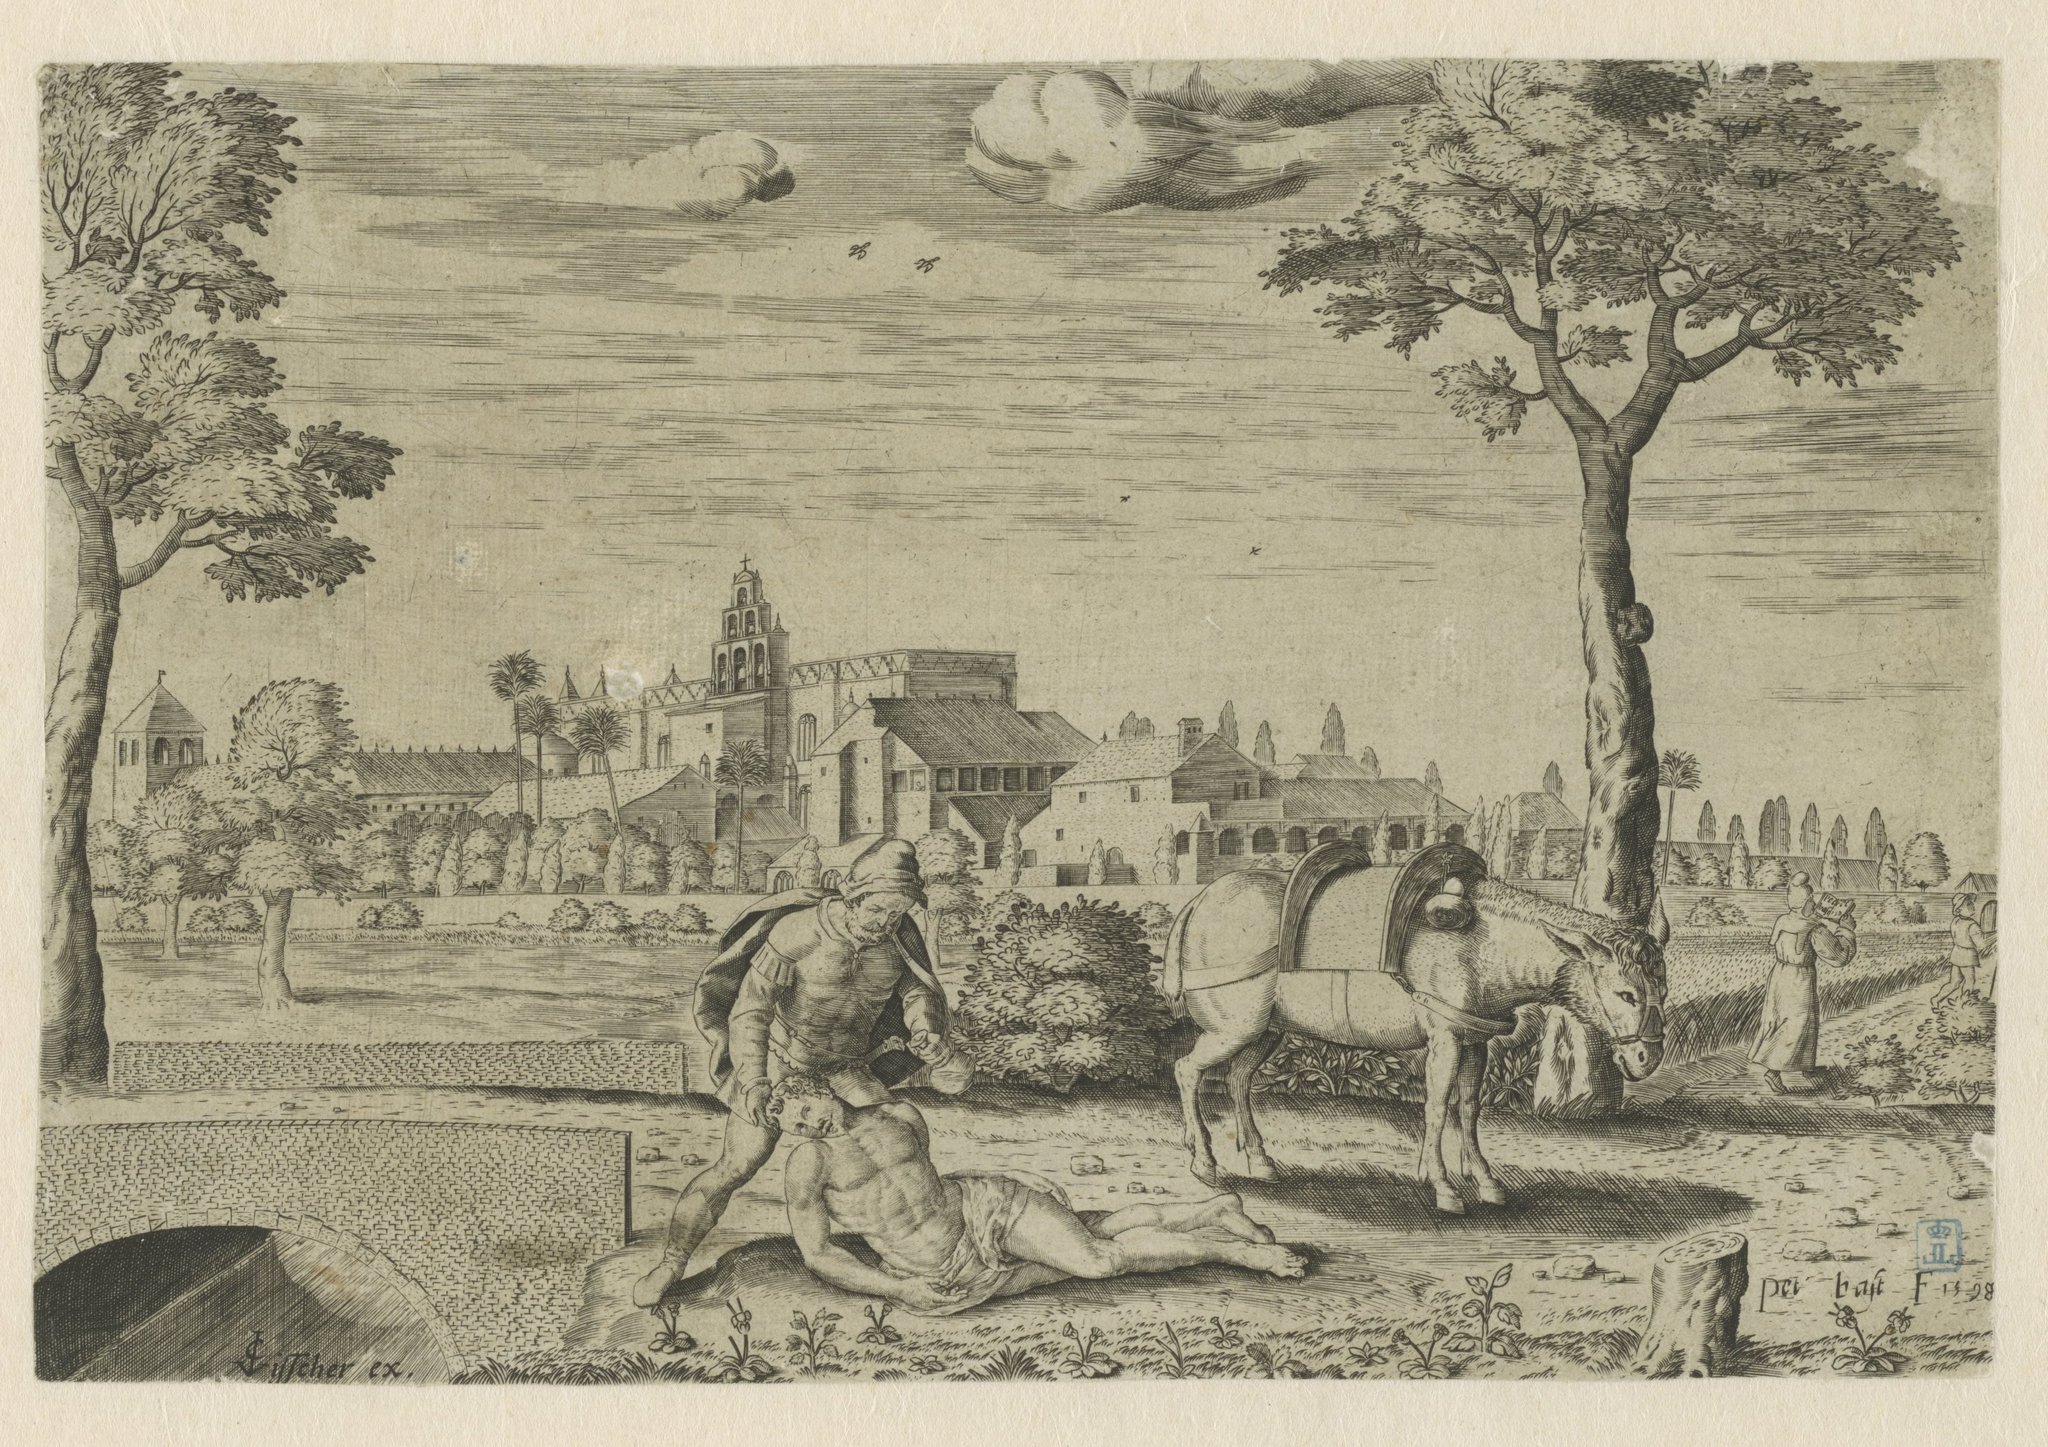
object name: print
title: Landschappen met bijbelse scènes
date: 1598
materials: paper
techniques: engraving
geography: amsterdam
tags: city-view in general; 'veduta', a samaritan tending the wounds of the traveller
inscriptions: collector's mark: Lugt 1741, collector's mark: Lugt 2228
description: Gezicht op een Italiaanse stad binnen lage stadsmuren. Op de voorgrond bij een bruggetje over een rivier helpt de barmhartige Samaritaan de reiziger die gewond op de grond ligt. Zijn ezel staat de wachten. Rechts de Farizeer en de priester lopend door de velden.